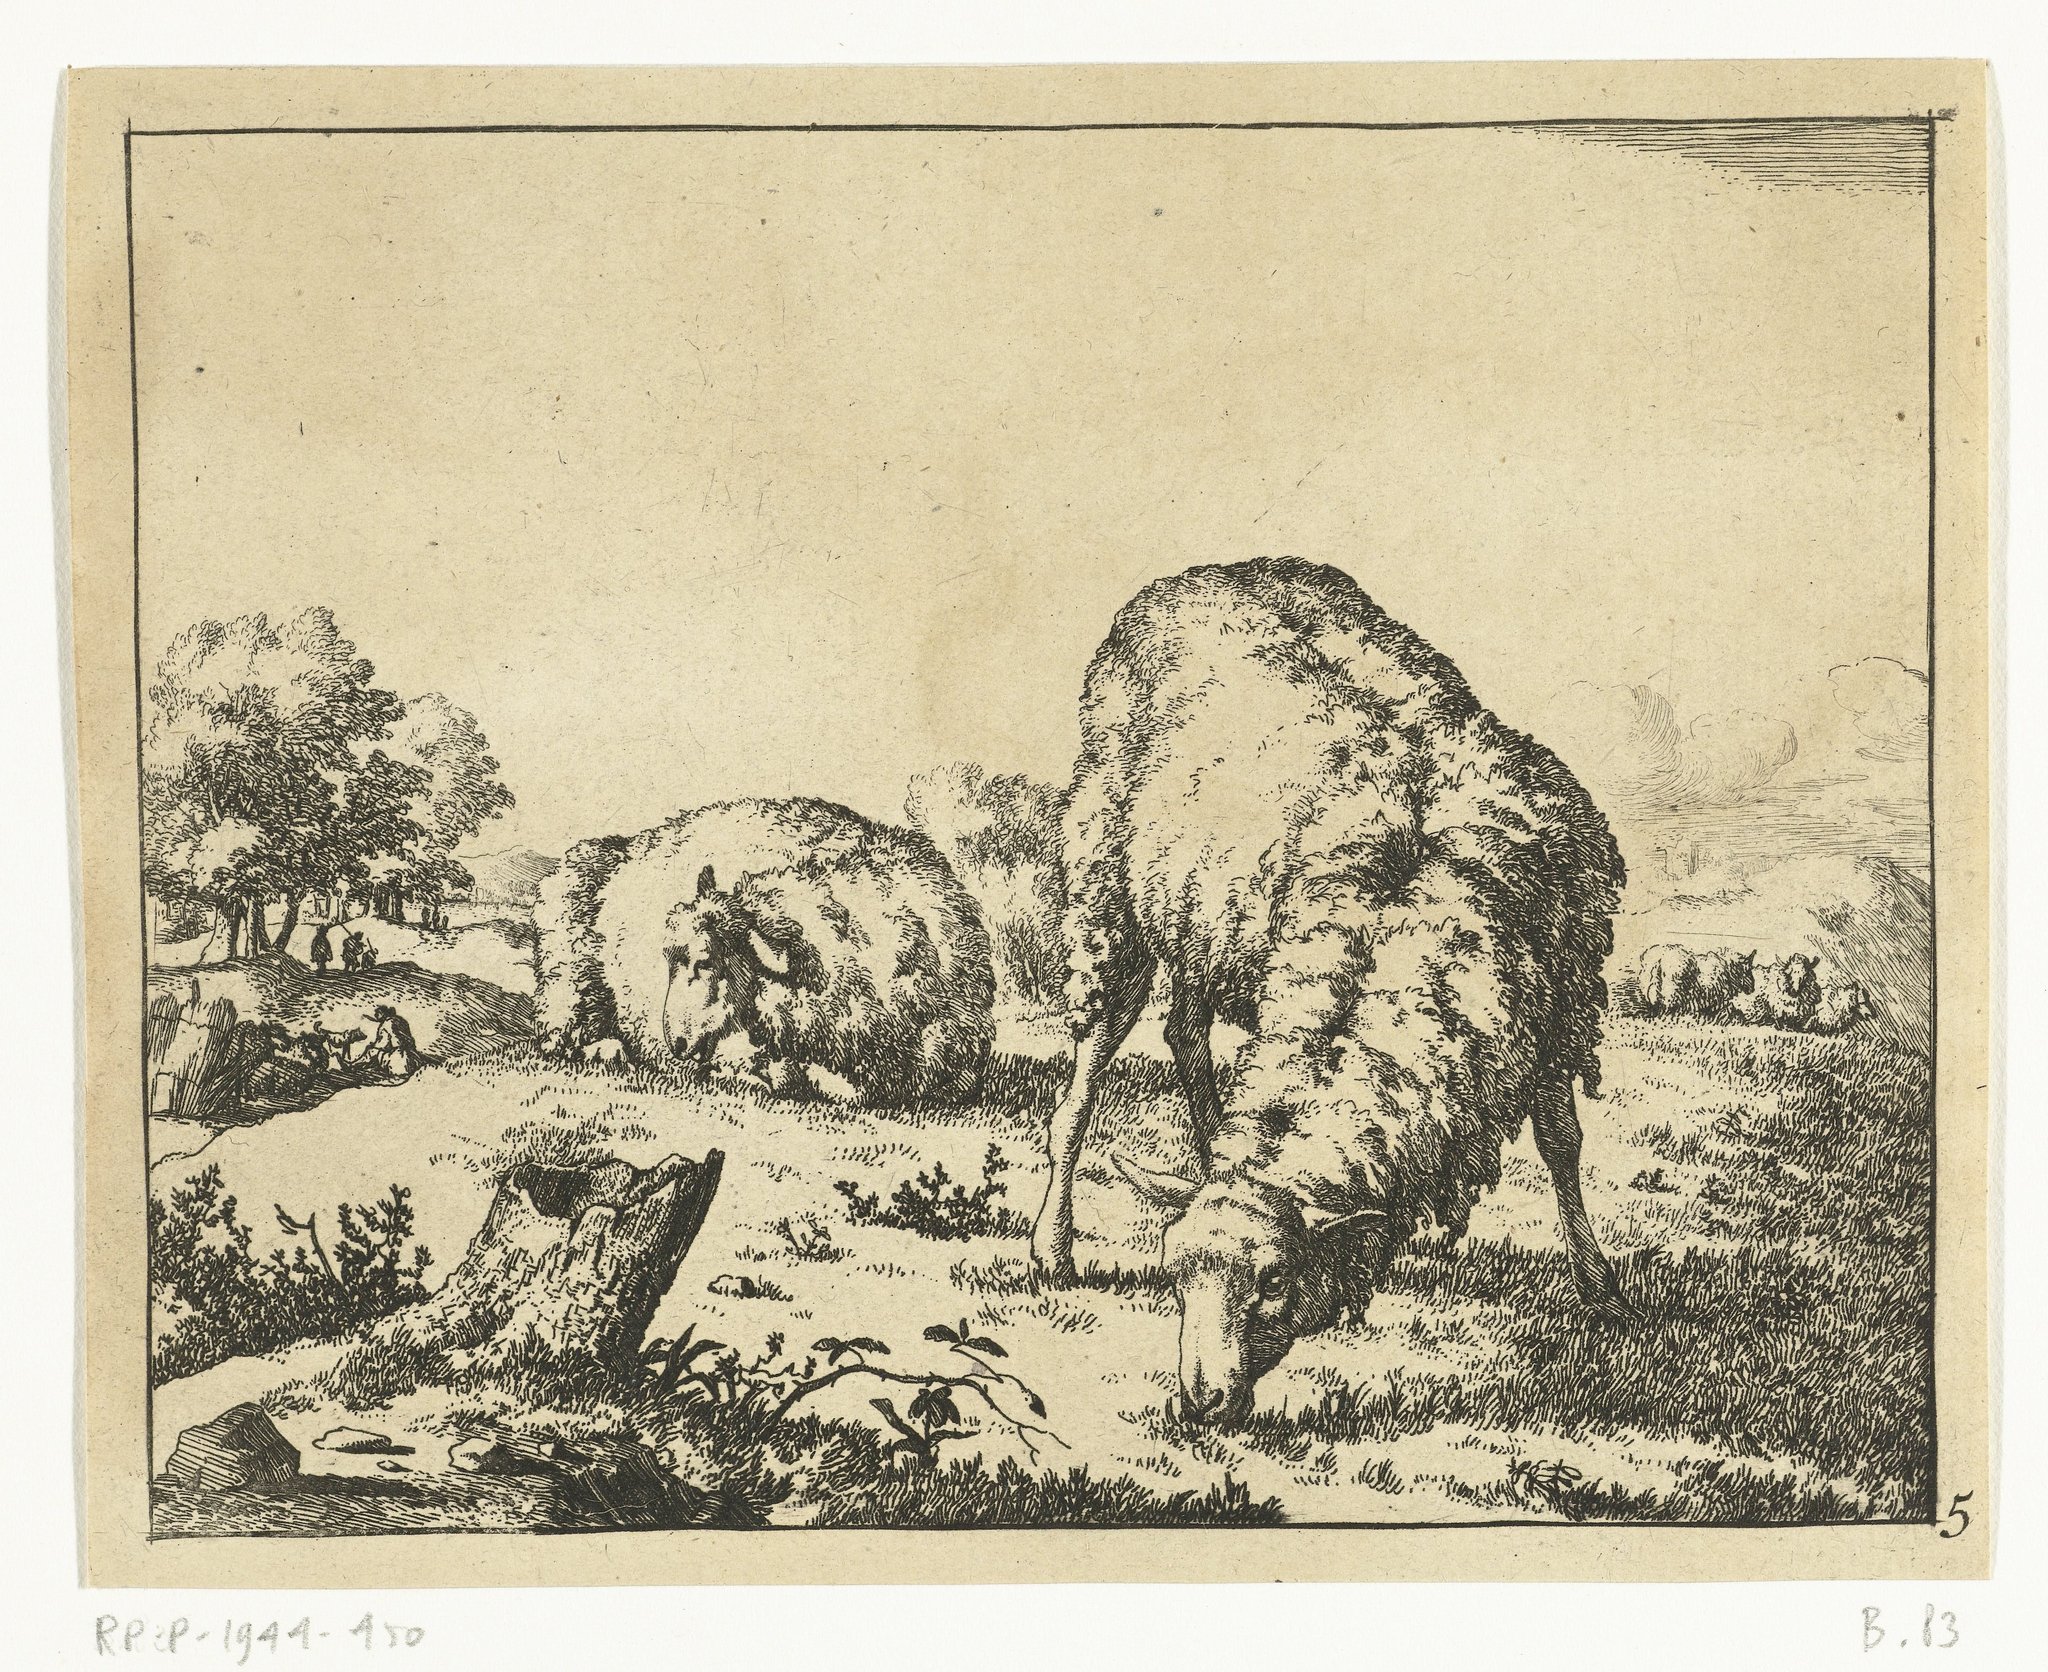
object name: print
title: Grazend schaap, bij boomstronk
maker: marcus de bye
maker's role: print maker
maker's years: 1639-1688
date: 1664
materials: paper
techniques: etching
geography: the hague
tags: sheep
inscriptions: collector's mark: Lugt 2228